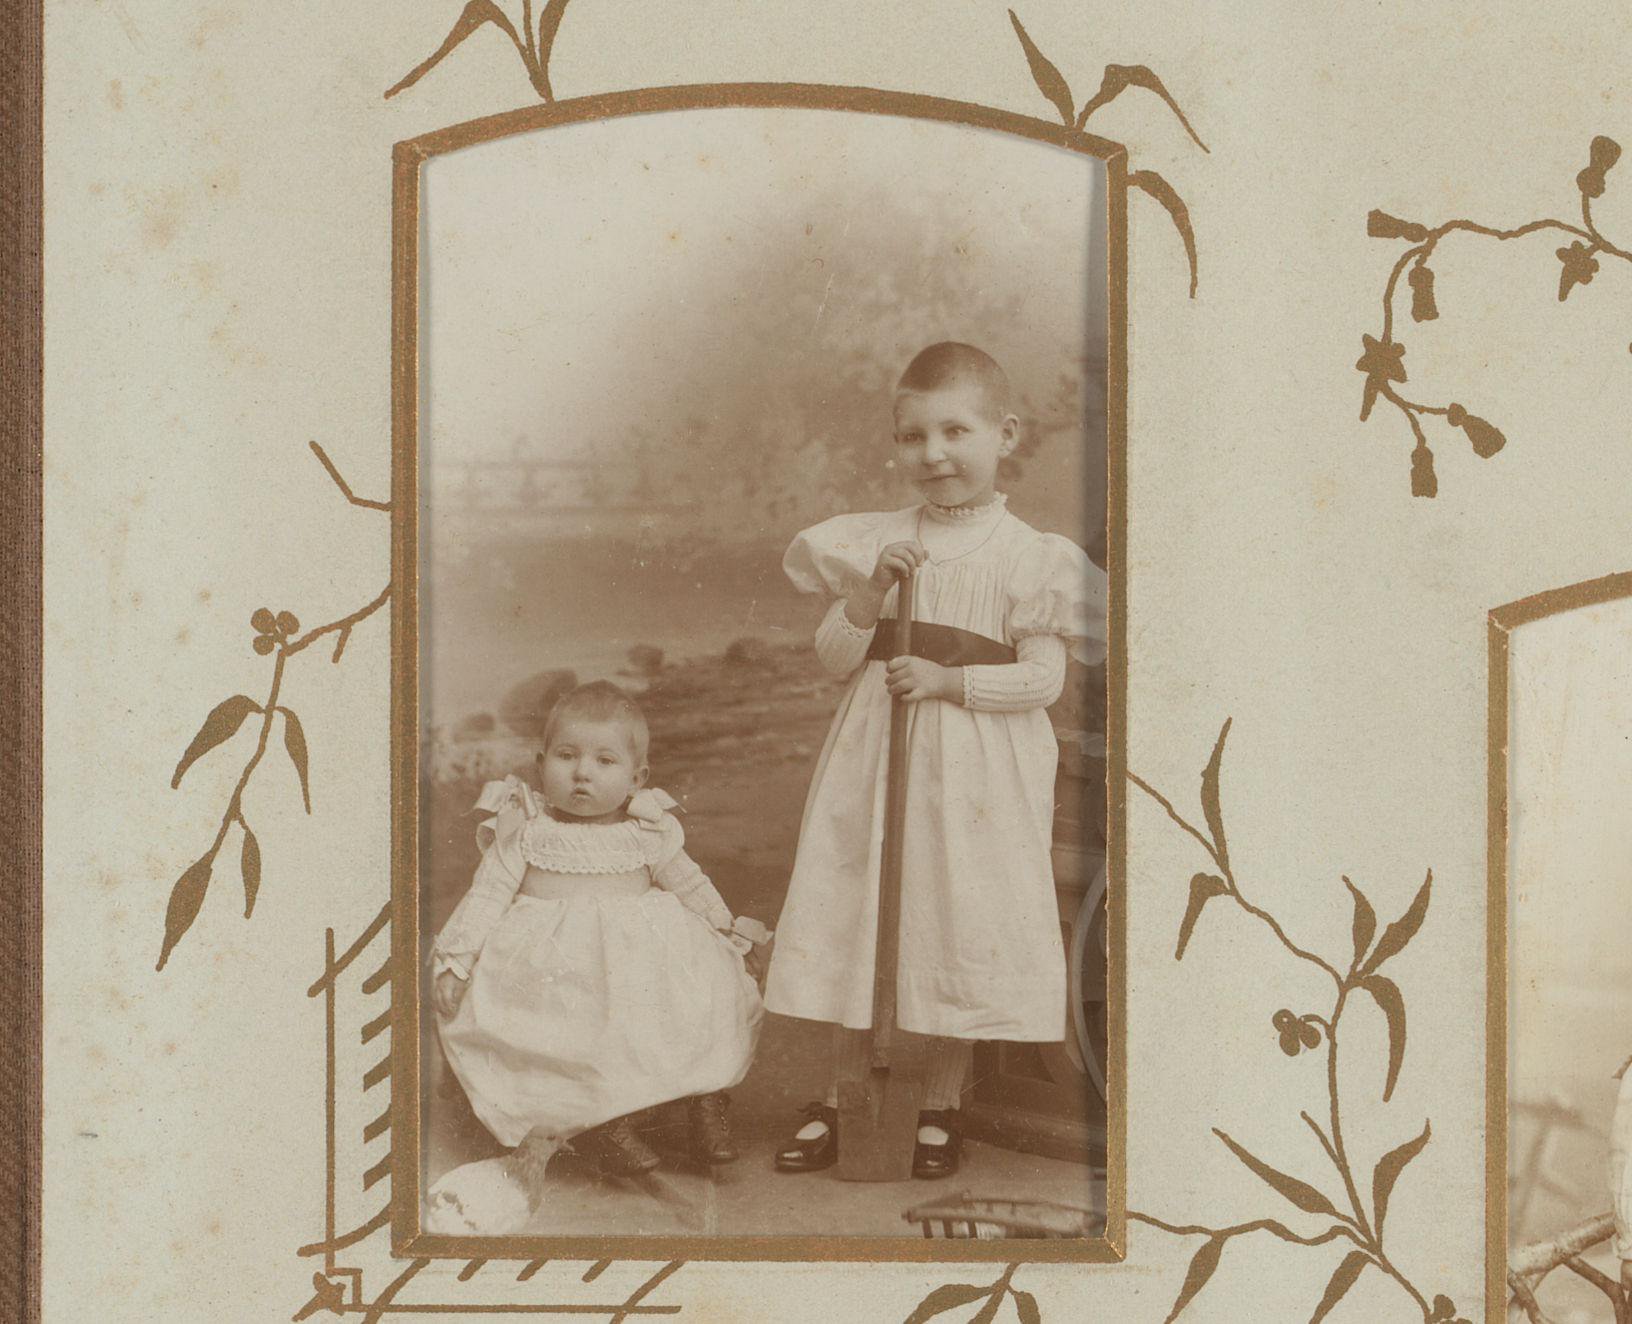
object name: photograph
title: Portret van twee kinderen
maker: carl bock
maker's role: fotograaf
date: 1860-1900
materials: cardboard, photographic support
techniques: collodion silver print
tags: child, historical persons, tot, toddler ~ the ages of man